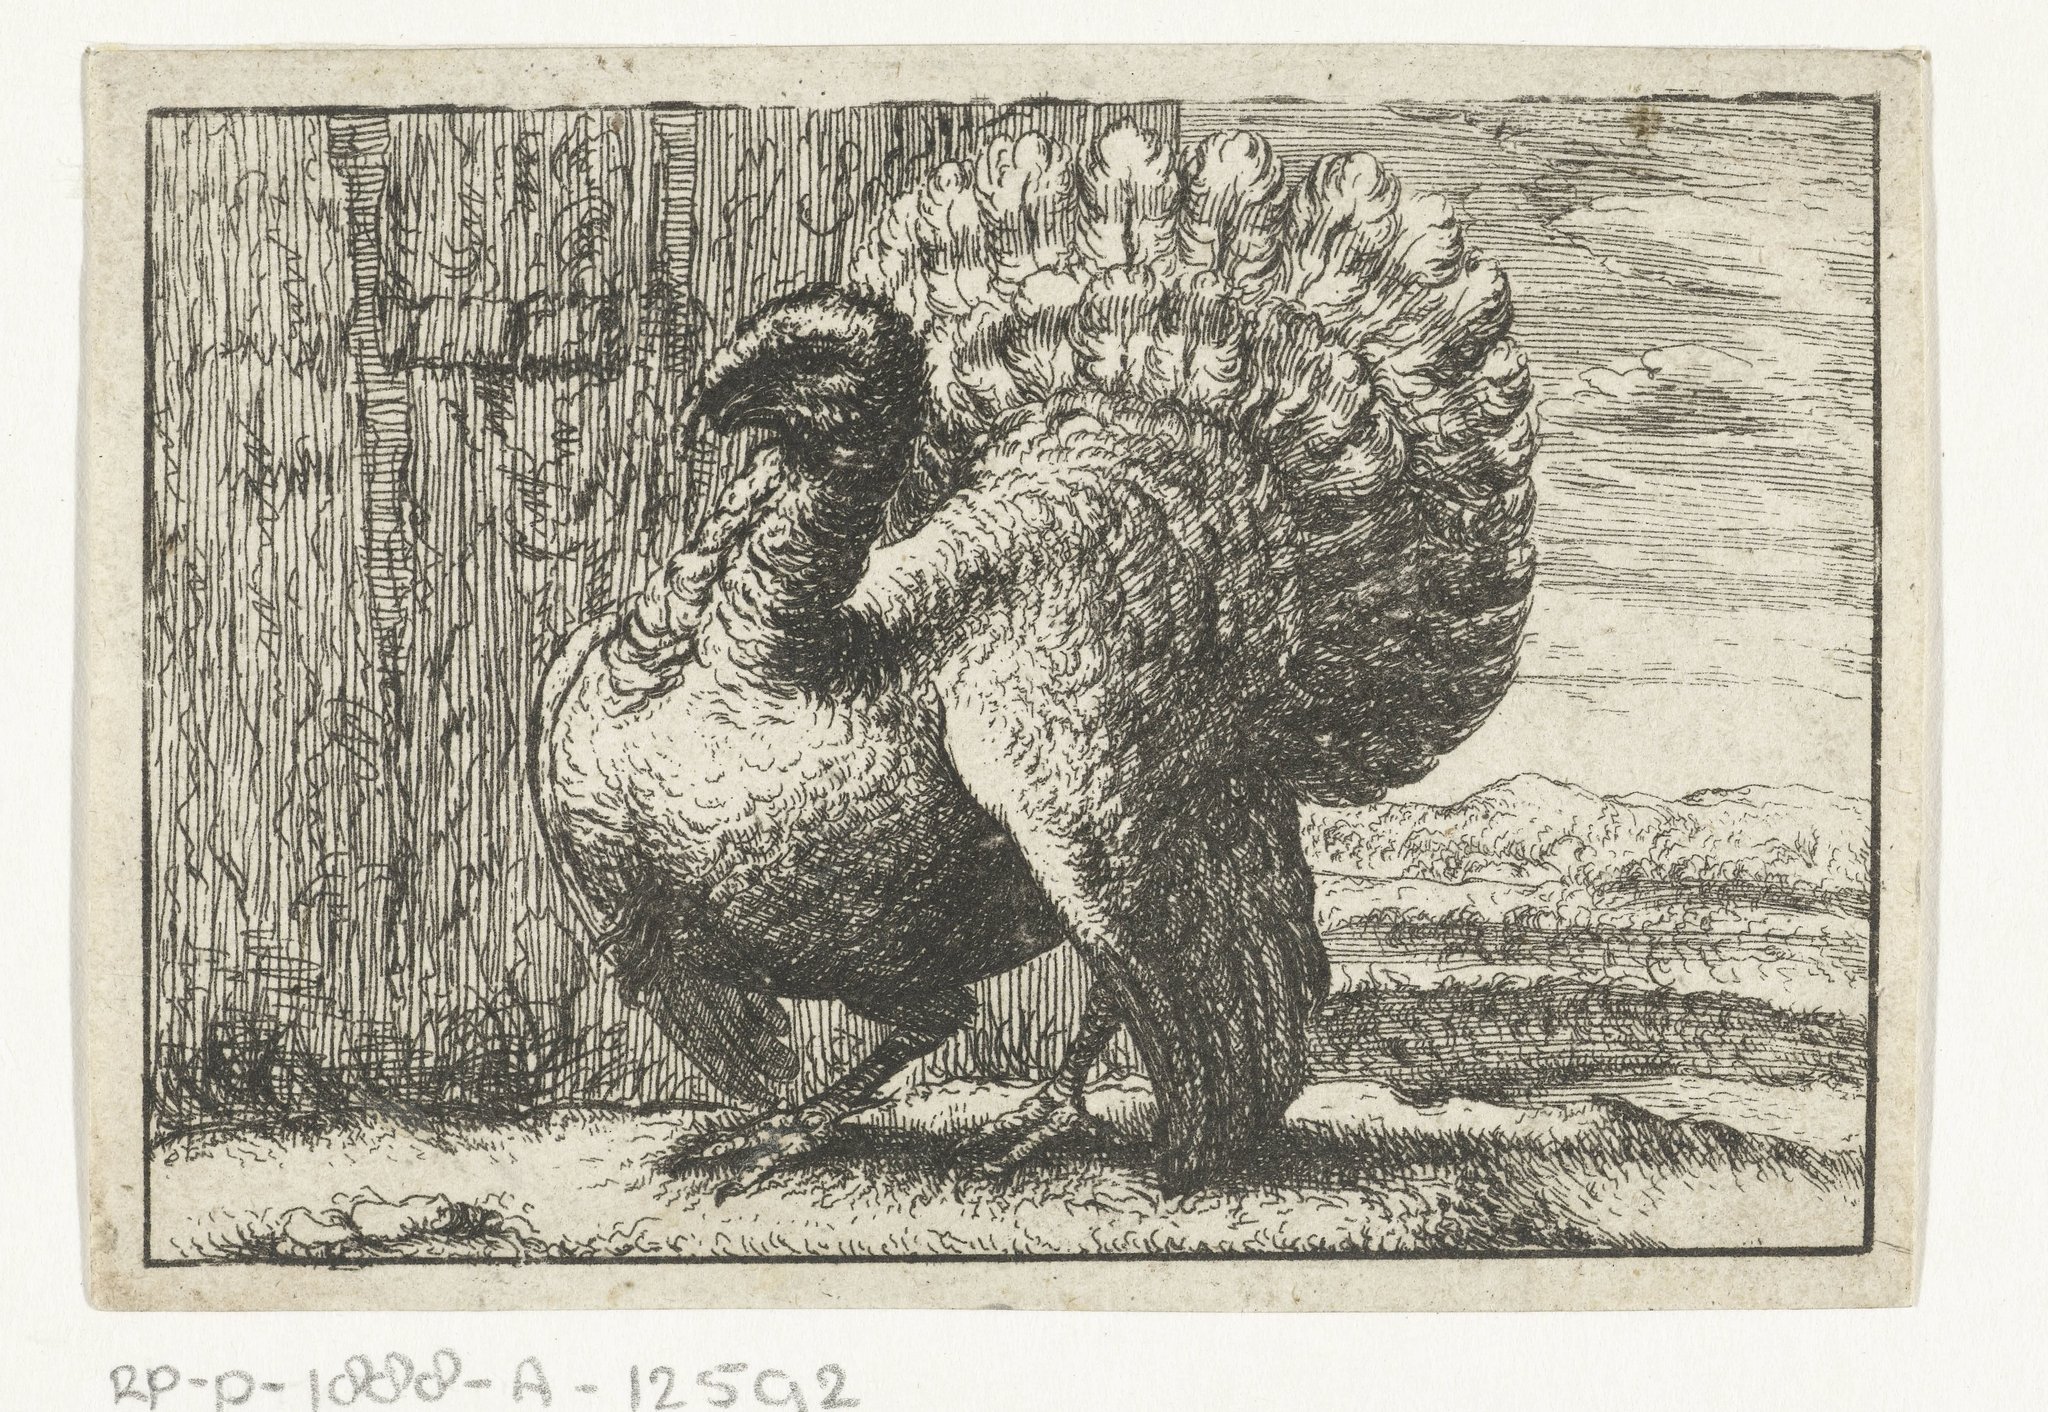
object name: print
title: Landschap met kalkoen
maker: Anonymous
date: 1659-1741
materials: paper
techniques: etching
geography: paris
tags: walker and runner birds: turkey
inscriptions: collector's mark: Lugt 2228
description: Kopie in spiegelbeeld naar een prent uit de serie Dertien vogelsoorten van Albert Flamen.